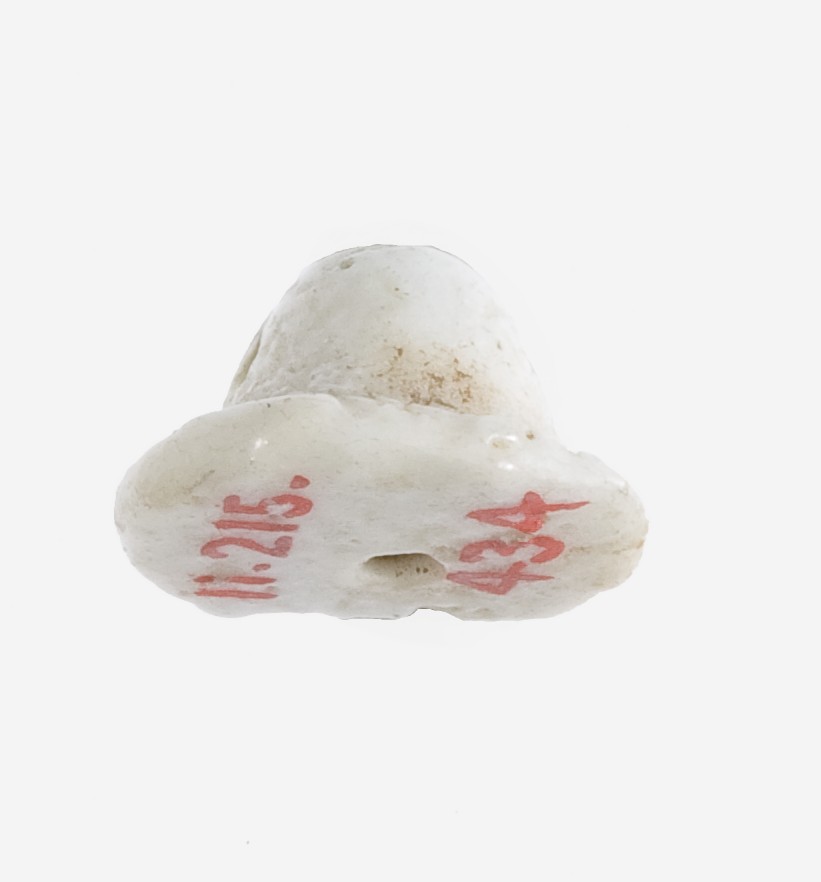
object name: pendant, umbel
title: Umbel Pendant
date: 1390-1352 BCE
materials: faience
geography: egypt